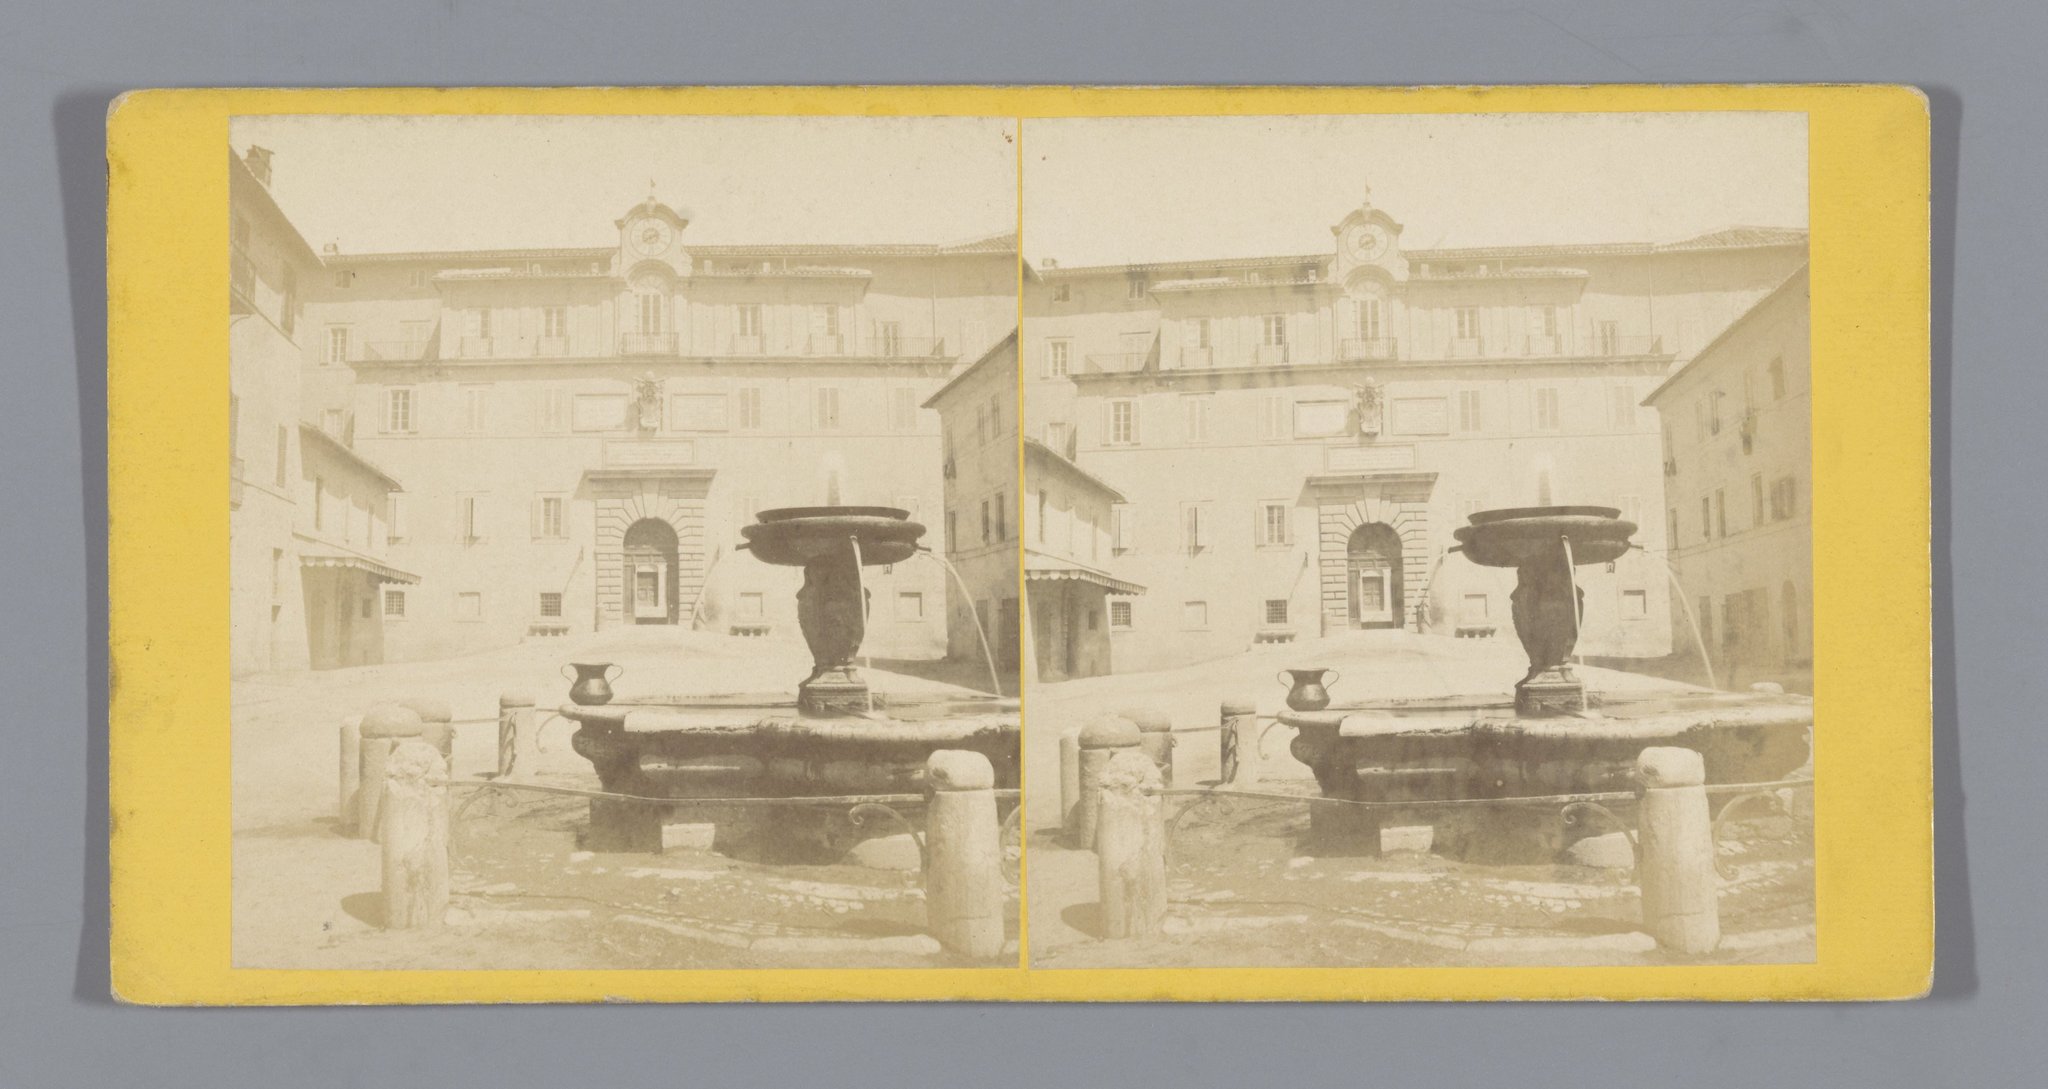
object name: stereograph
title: Palais de Castel-Gandolphe, résidence d'été de Sa Sainteté Pie IX (Albano)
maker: Anonymous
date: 1850-1880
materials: cardboard, photographic support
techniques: albumen print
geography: castel gandolfo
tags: palace, ornamental fountain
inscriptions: number: ‘1673.’